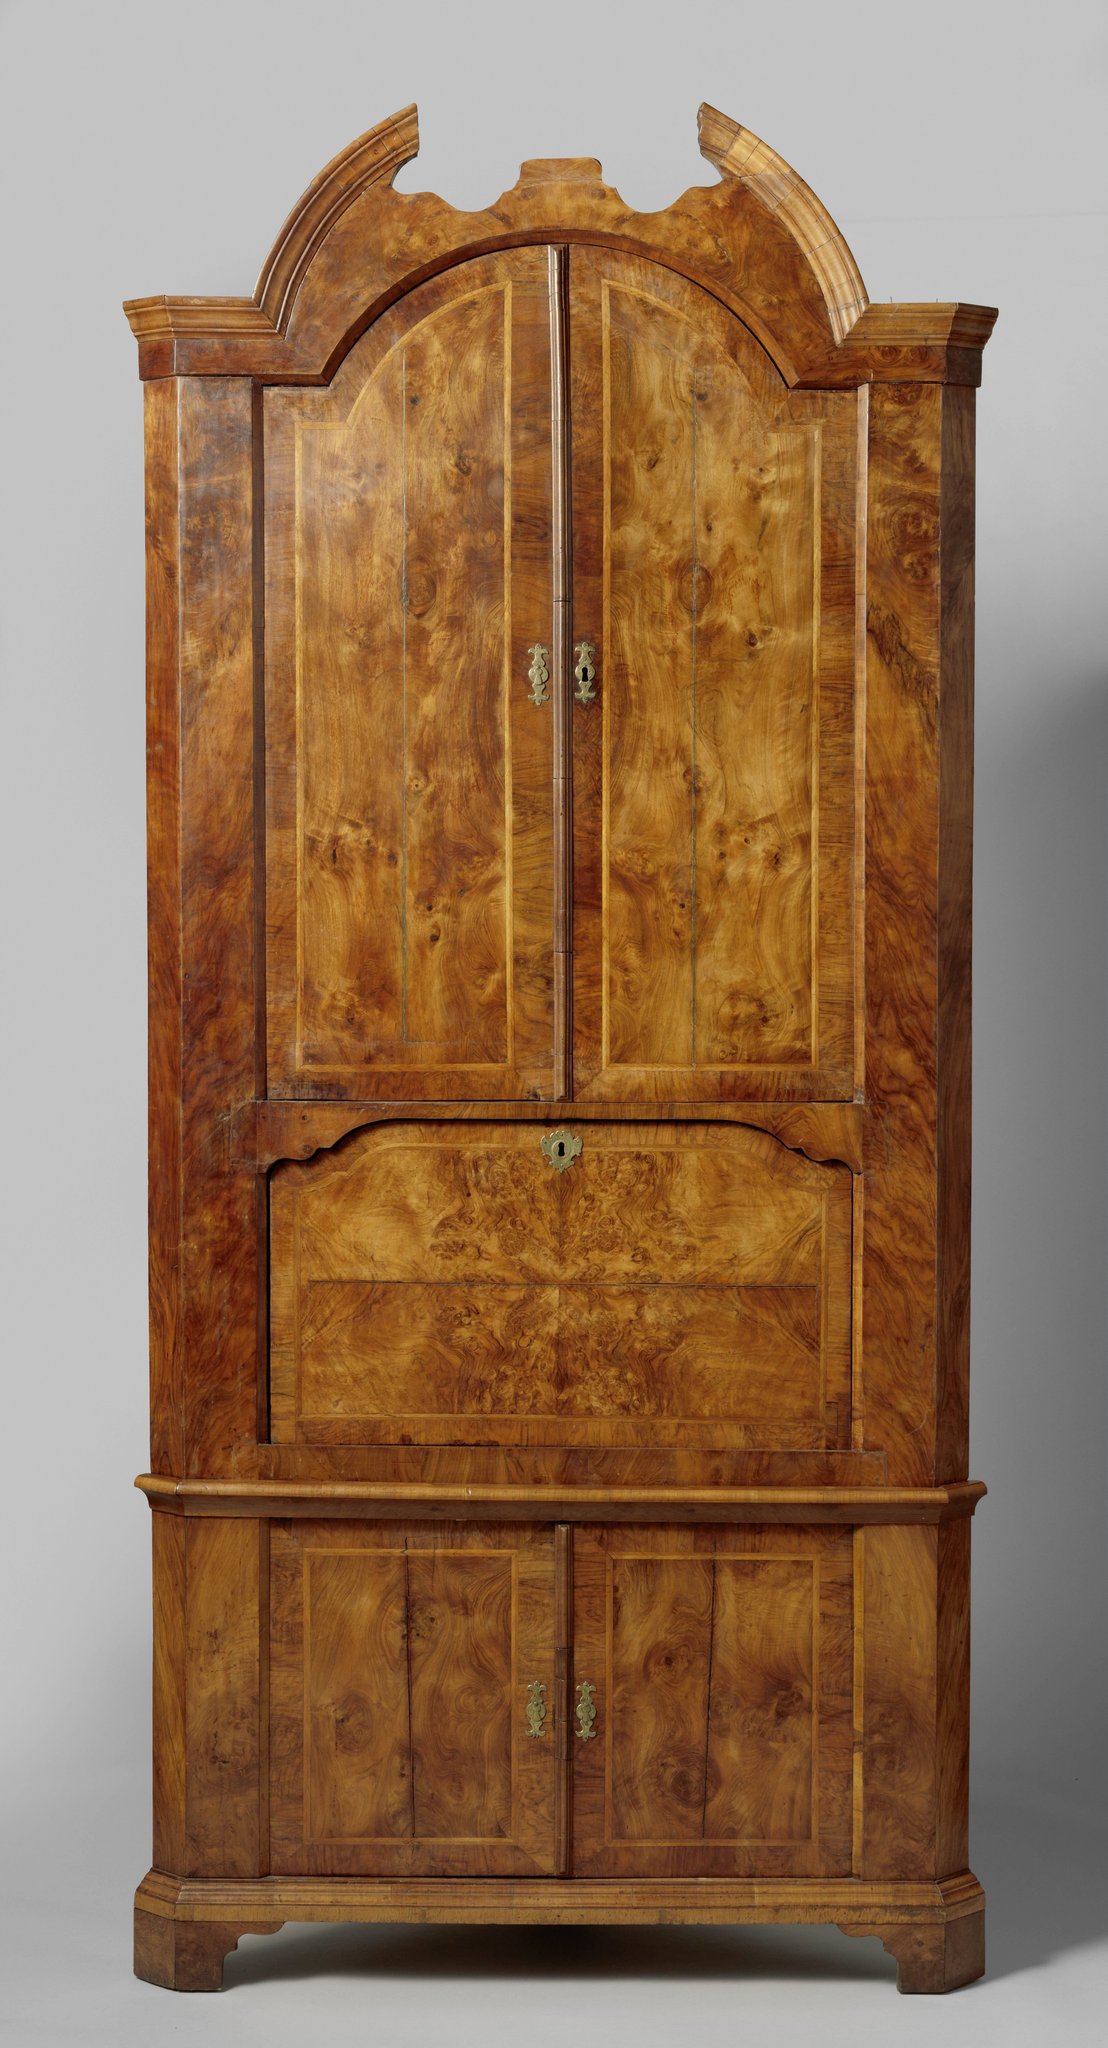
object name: case furniture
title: Driedelige hoekkast met o.a. segmentvormig gebroken fronton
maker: Anonymous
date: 1700-1749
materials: wood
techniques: lacquer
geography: northern netherlands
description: Corner buffet. Oak, veneered with burr walnut, the interior japanned. Netherlands, c. 1720 - 1740.